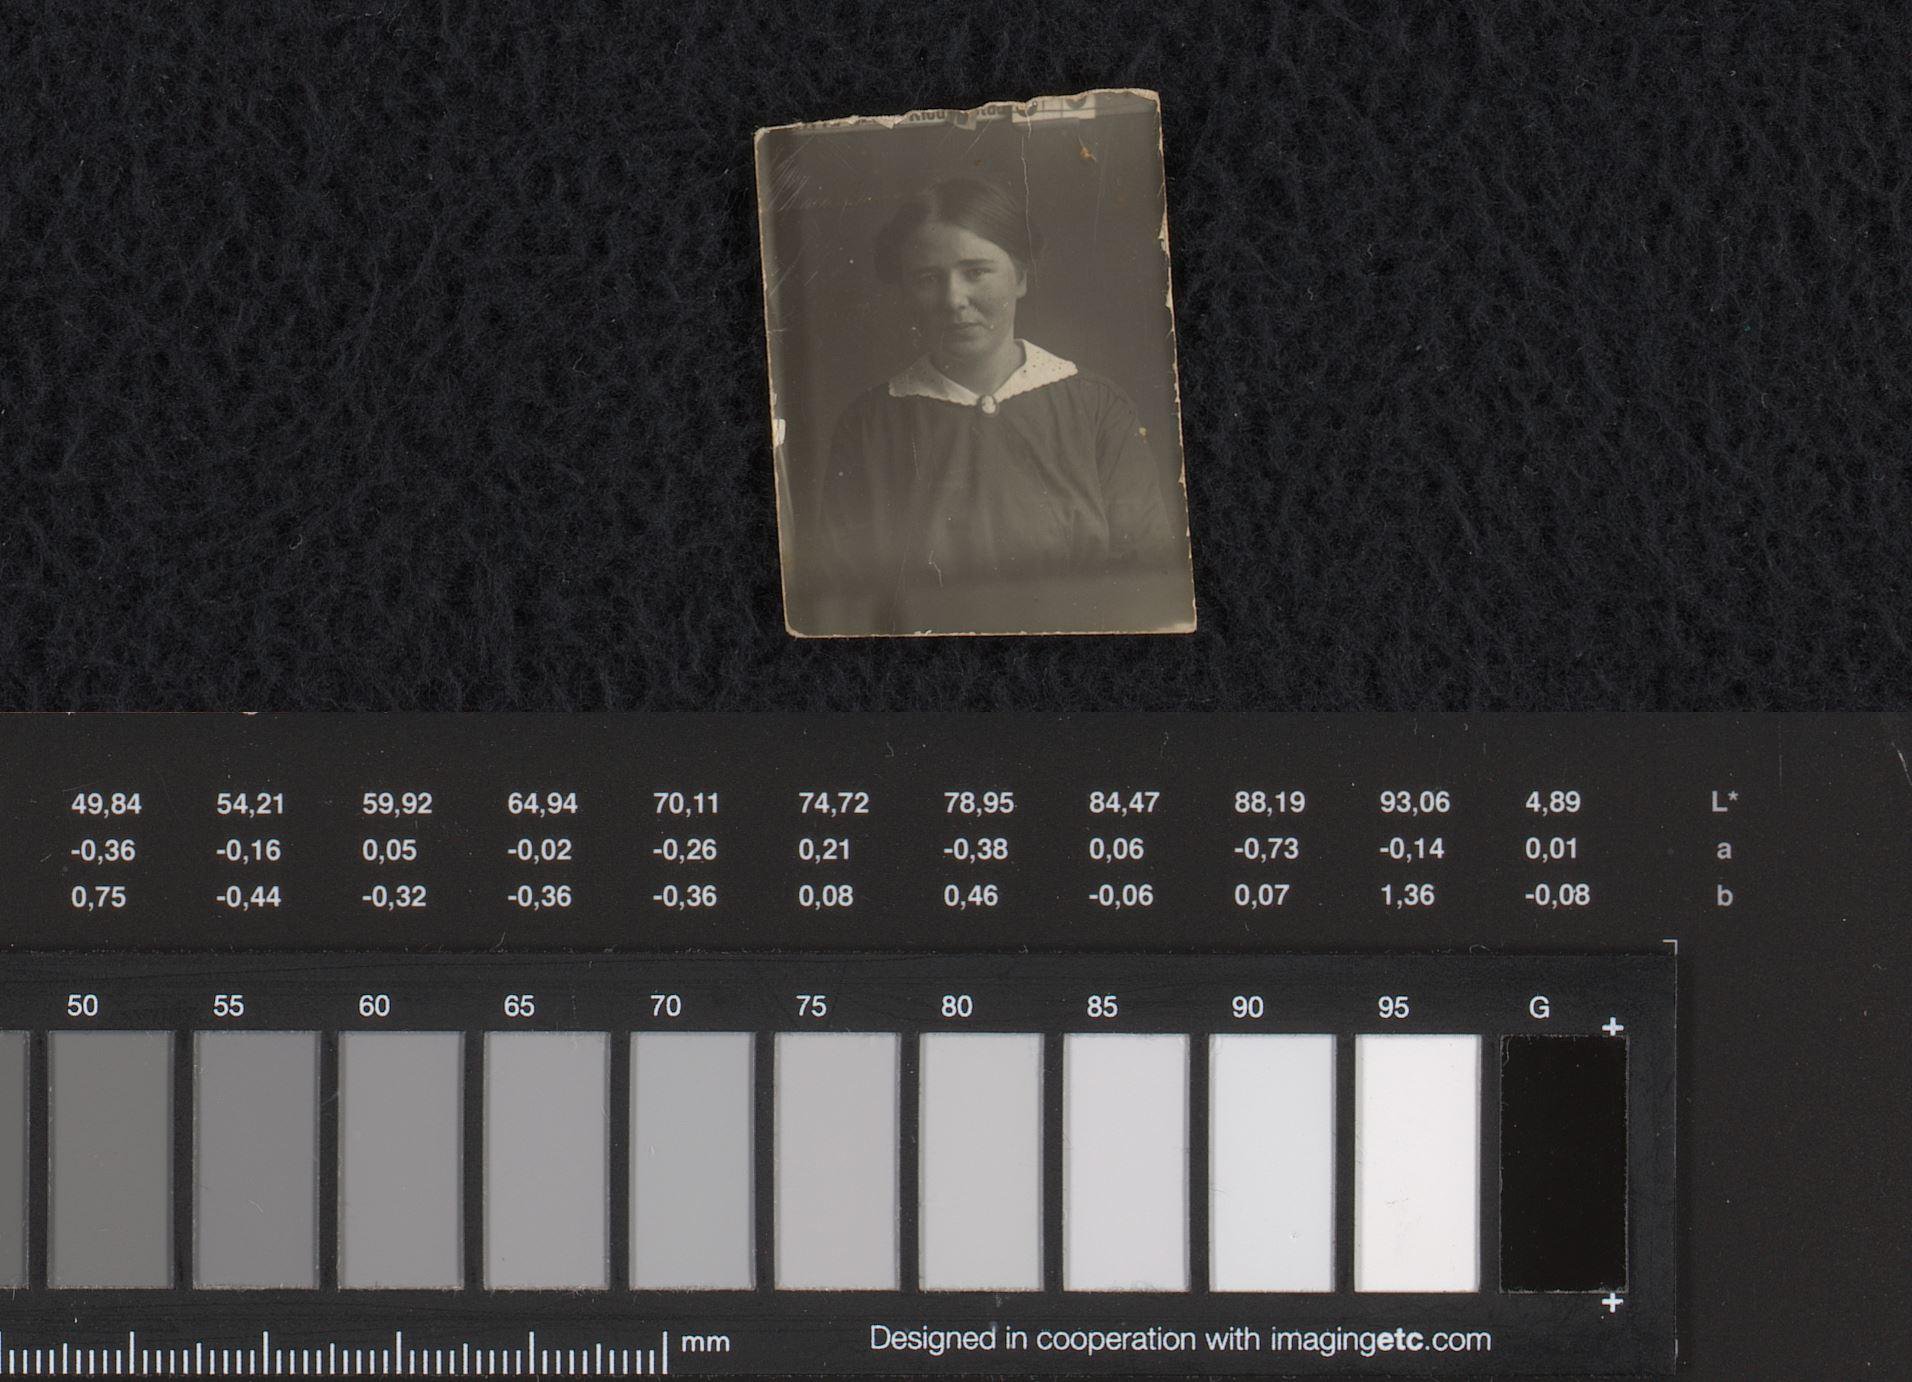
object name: snapshot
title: Portret van een onbekende jonge vrouw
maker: Anonymous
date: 1912-1916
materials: paper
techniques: gelatin silver print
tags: anonymous historical person portrayed - bb - woman